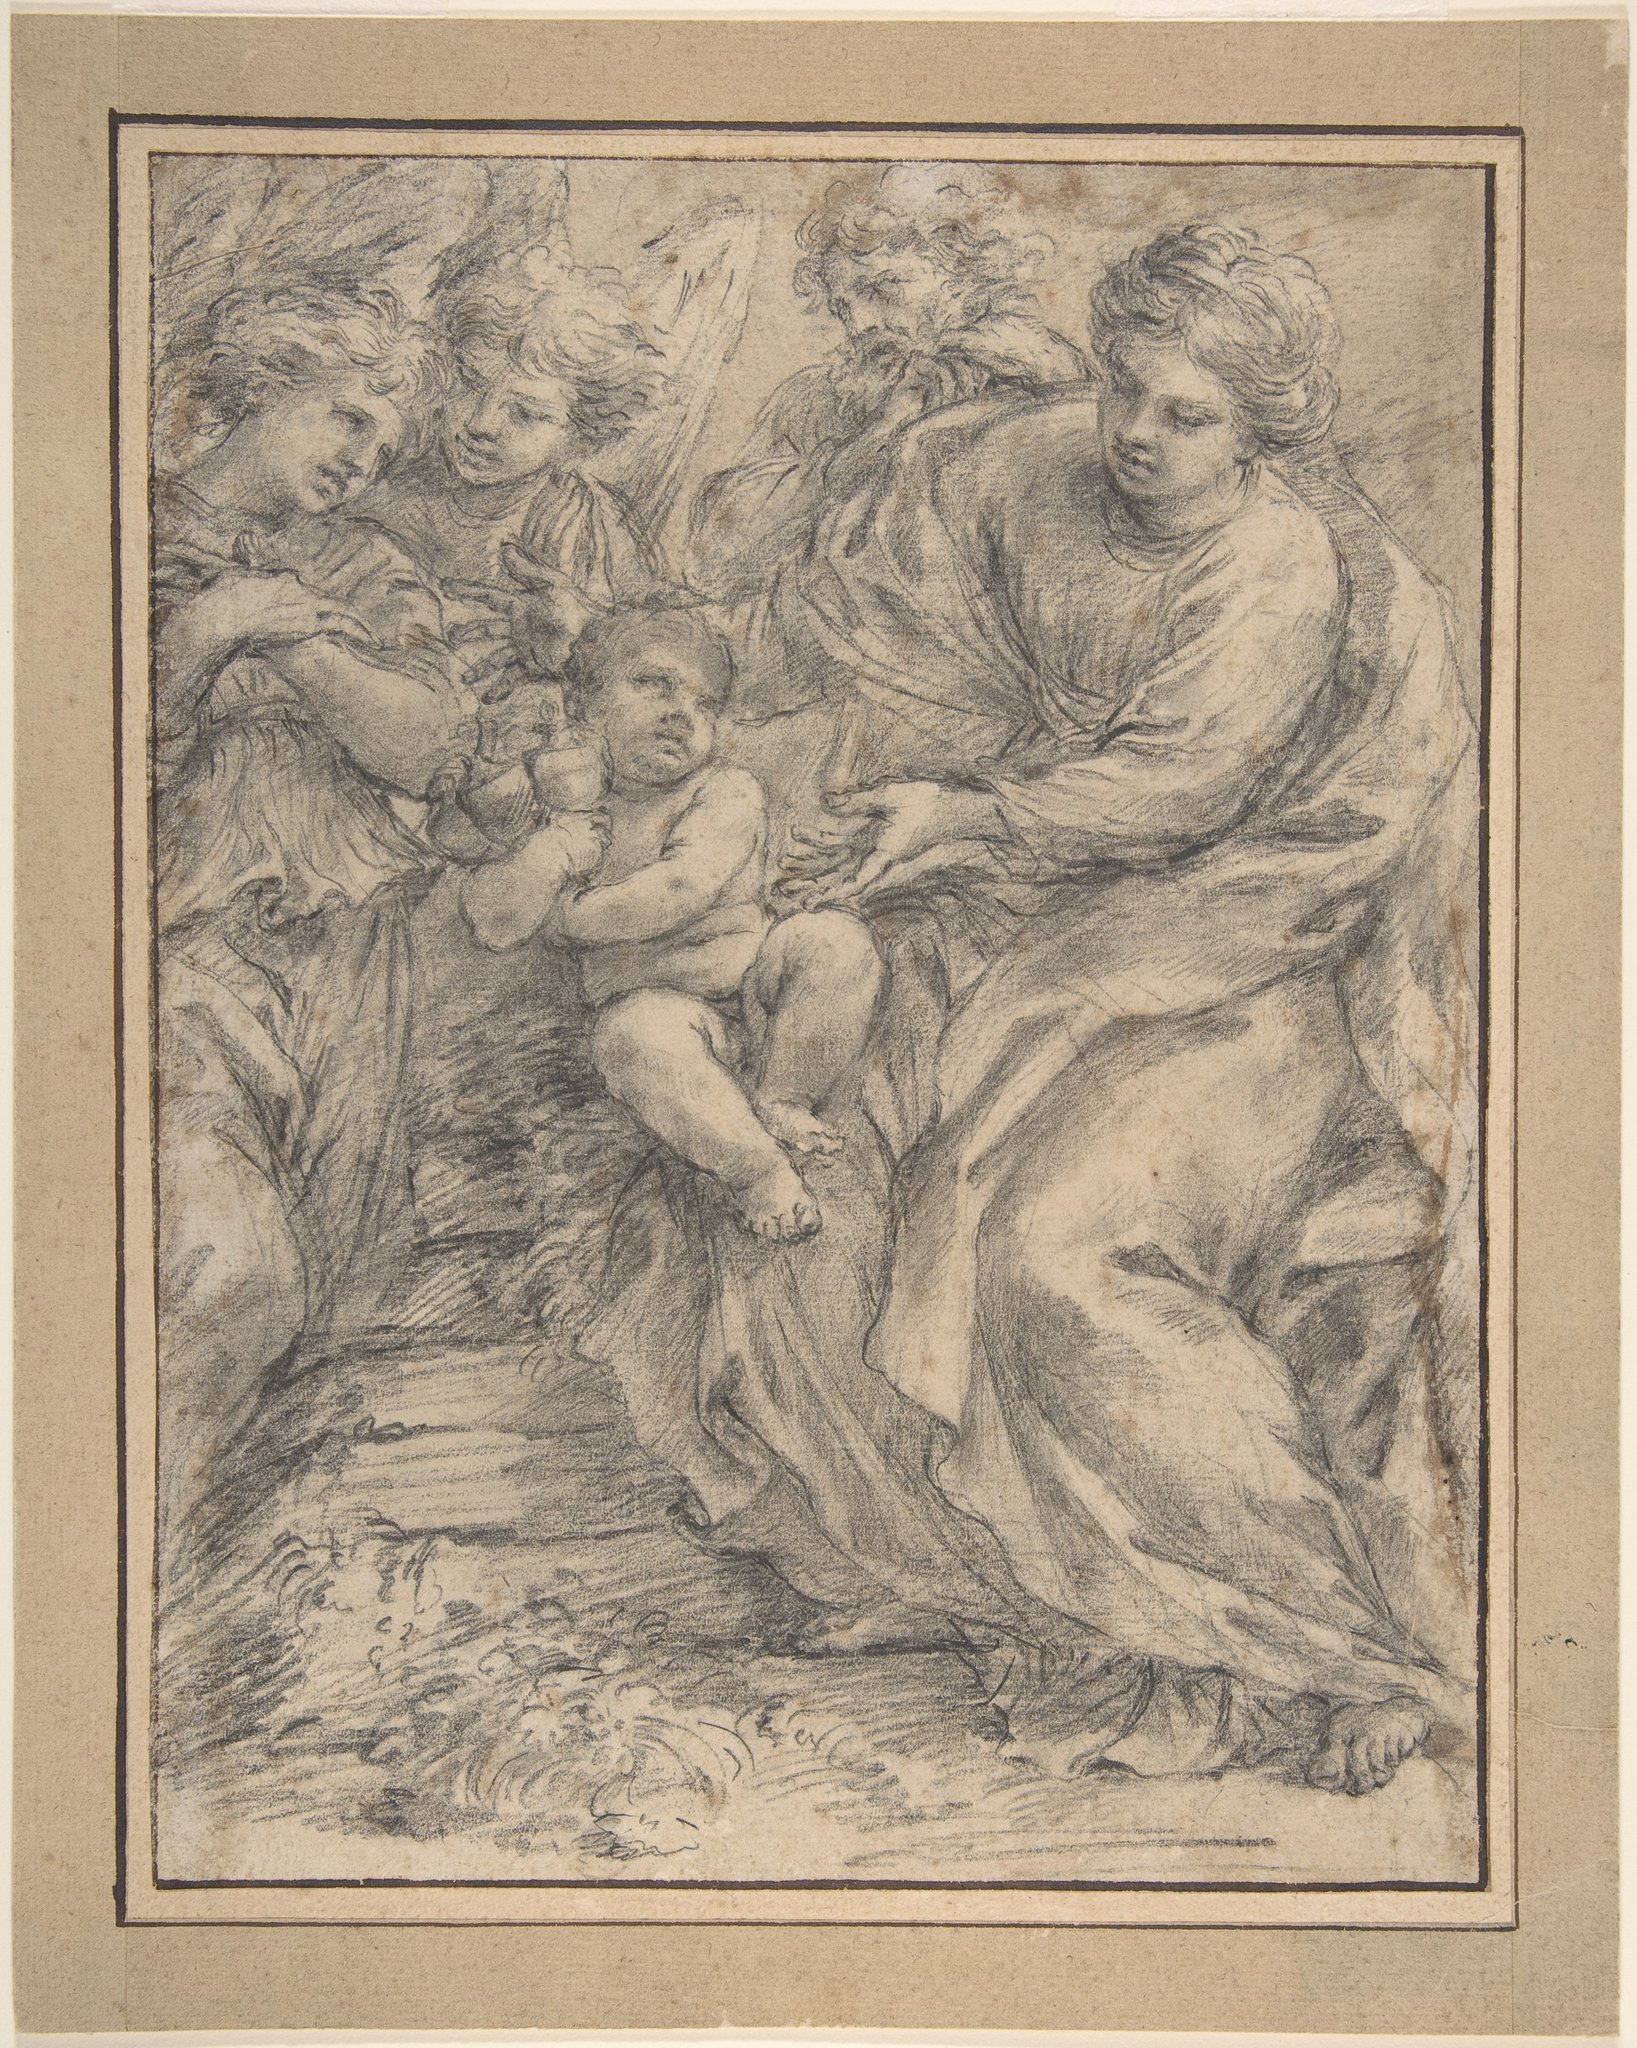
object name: drawing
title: The Holy Family with Two Angels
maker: alessandro algardi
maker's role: artist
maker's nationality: italian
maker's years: 1598-1654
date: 1598-1654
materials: chalk, ink, paper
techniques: pen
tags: angels,holy family